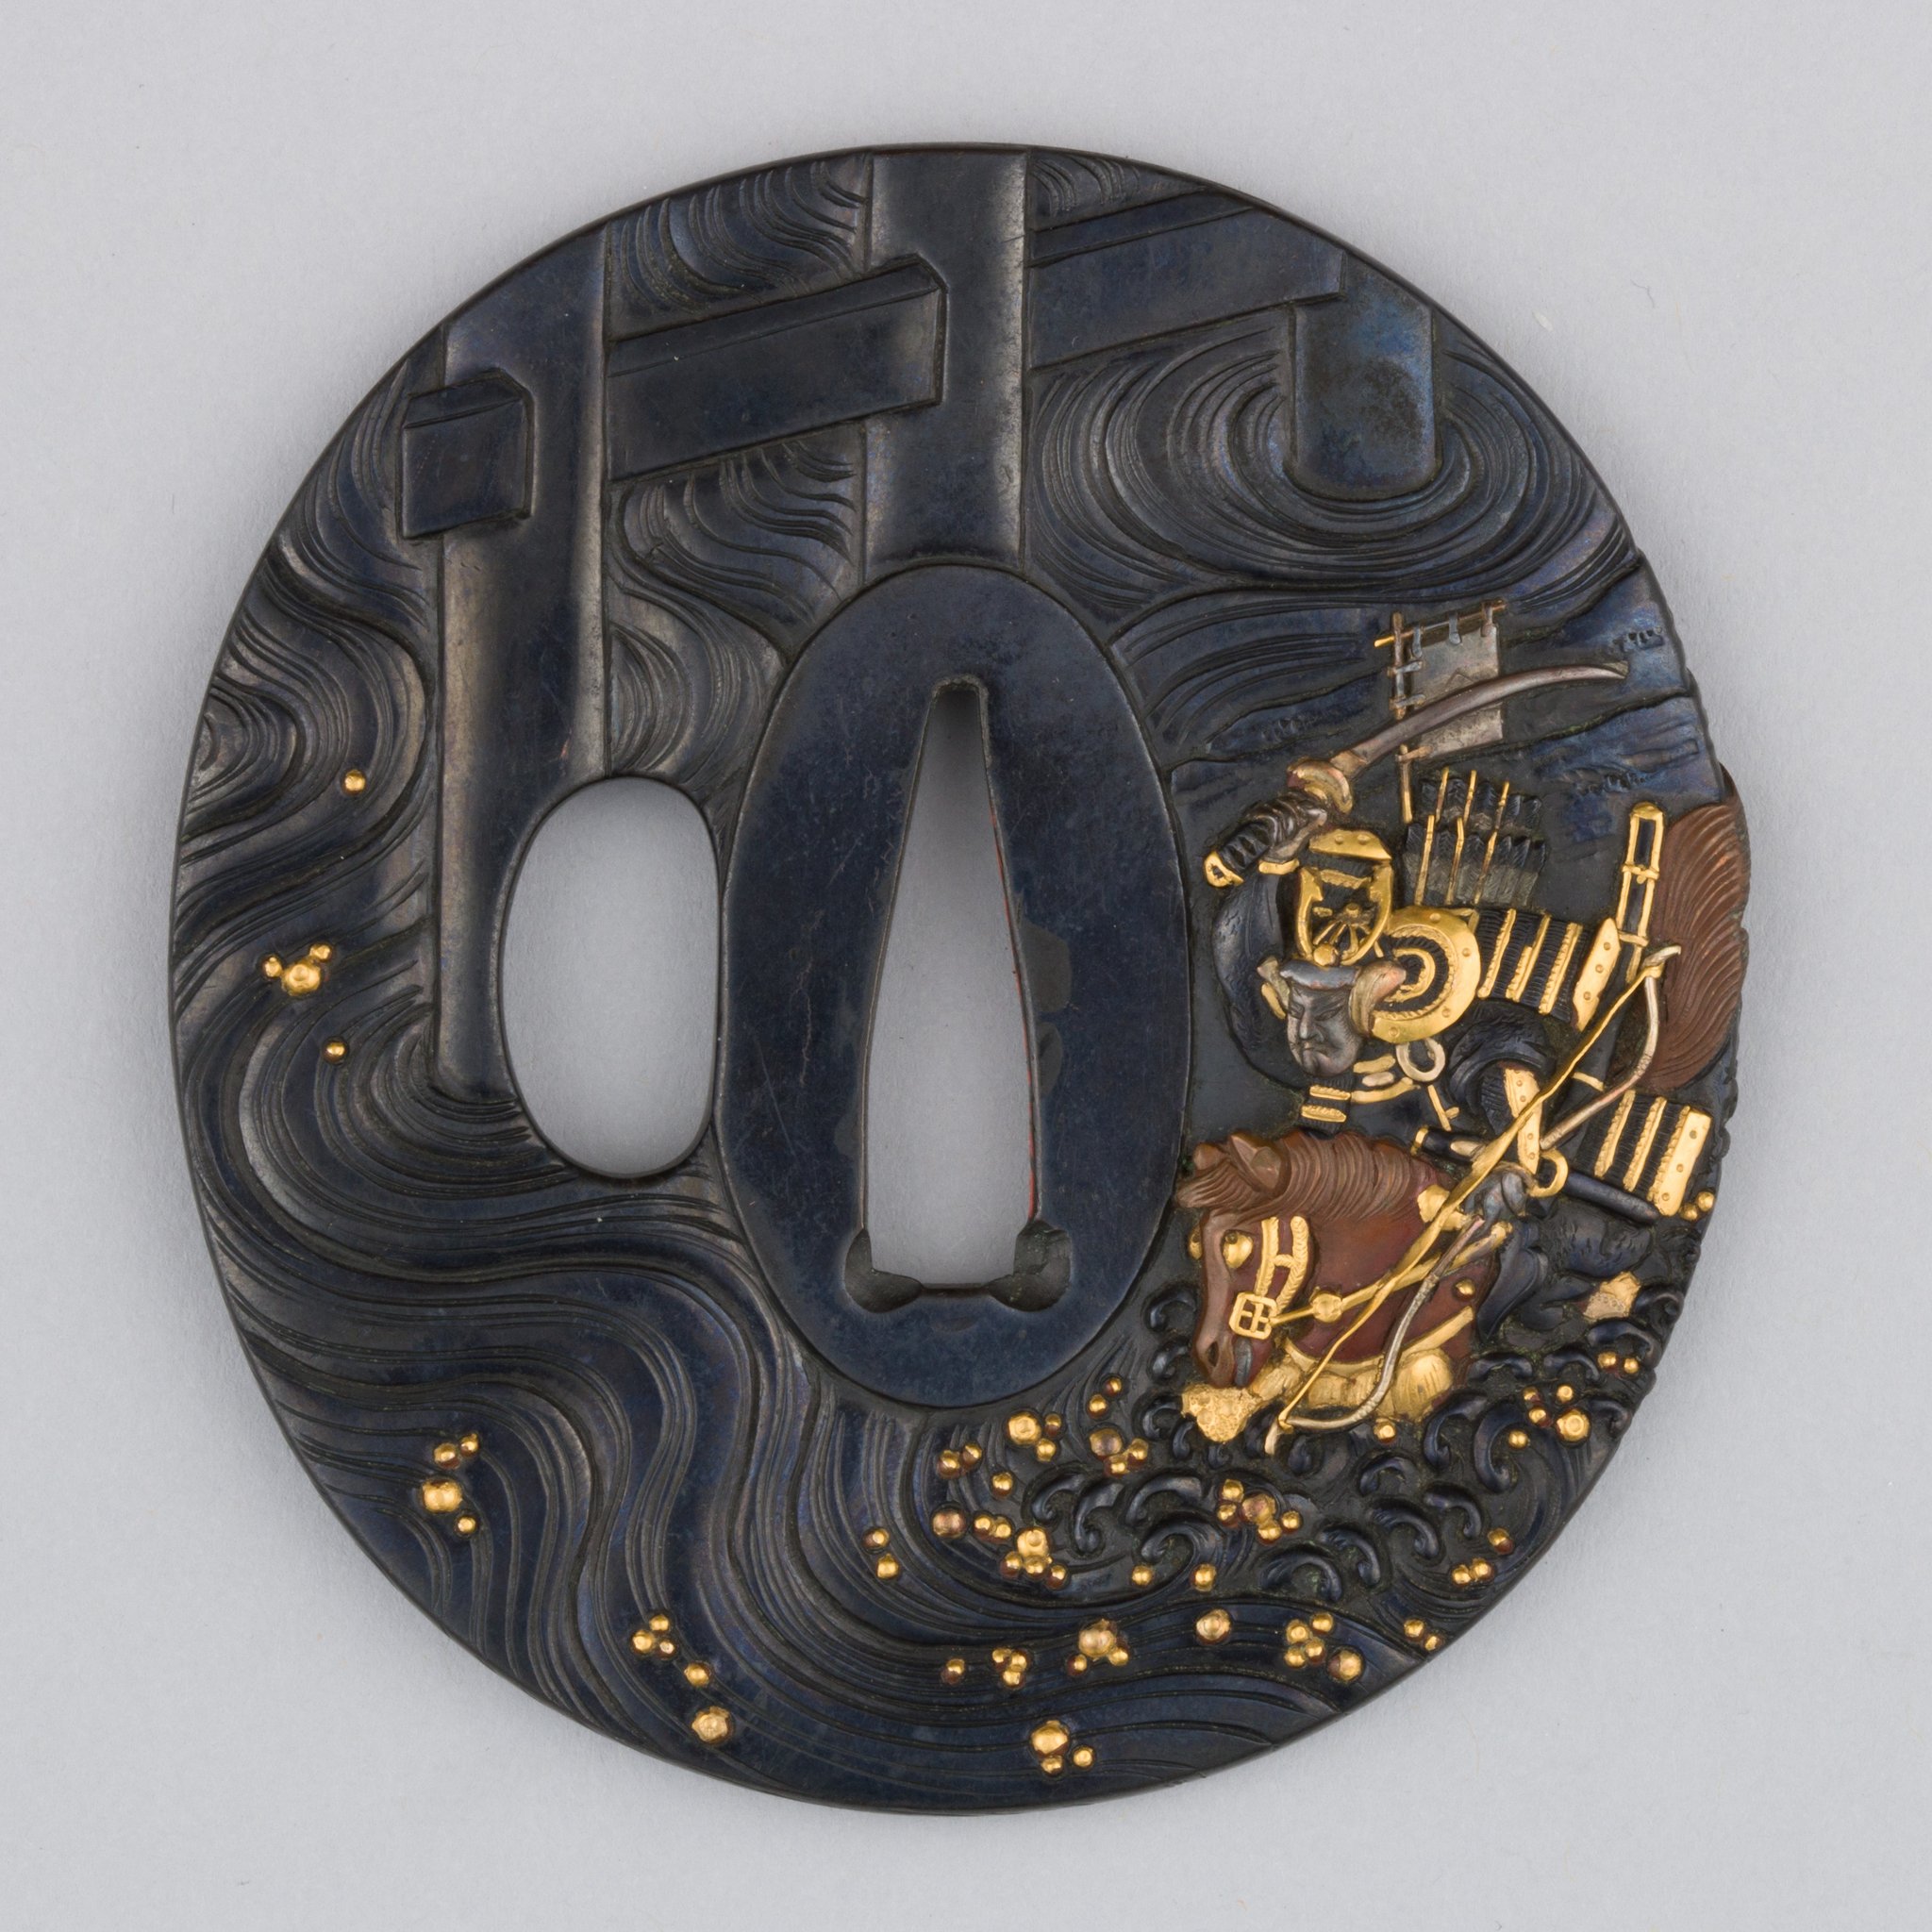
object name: sword guard tsuba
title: Sword Guard (Tsuba)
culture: japanese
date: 1615-1868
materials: copper, gold alloy, gold, silver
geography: japan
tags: human figures,horses